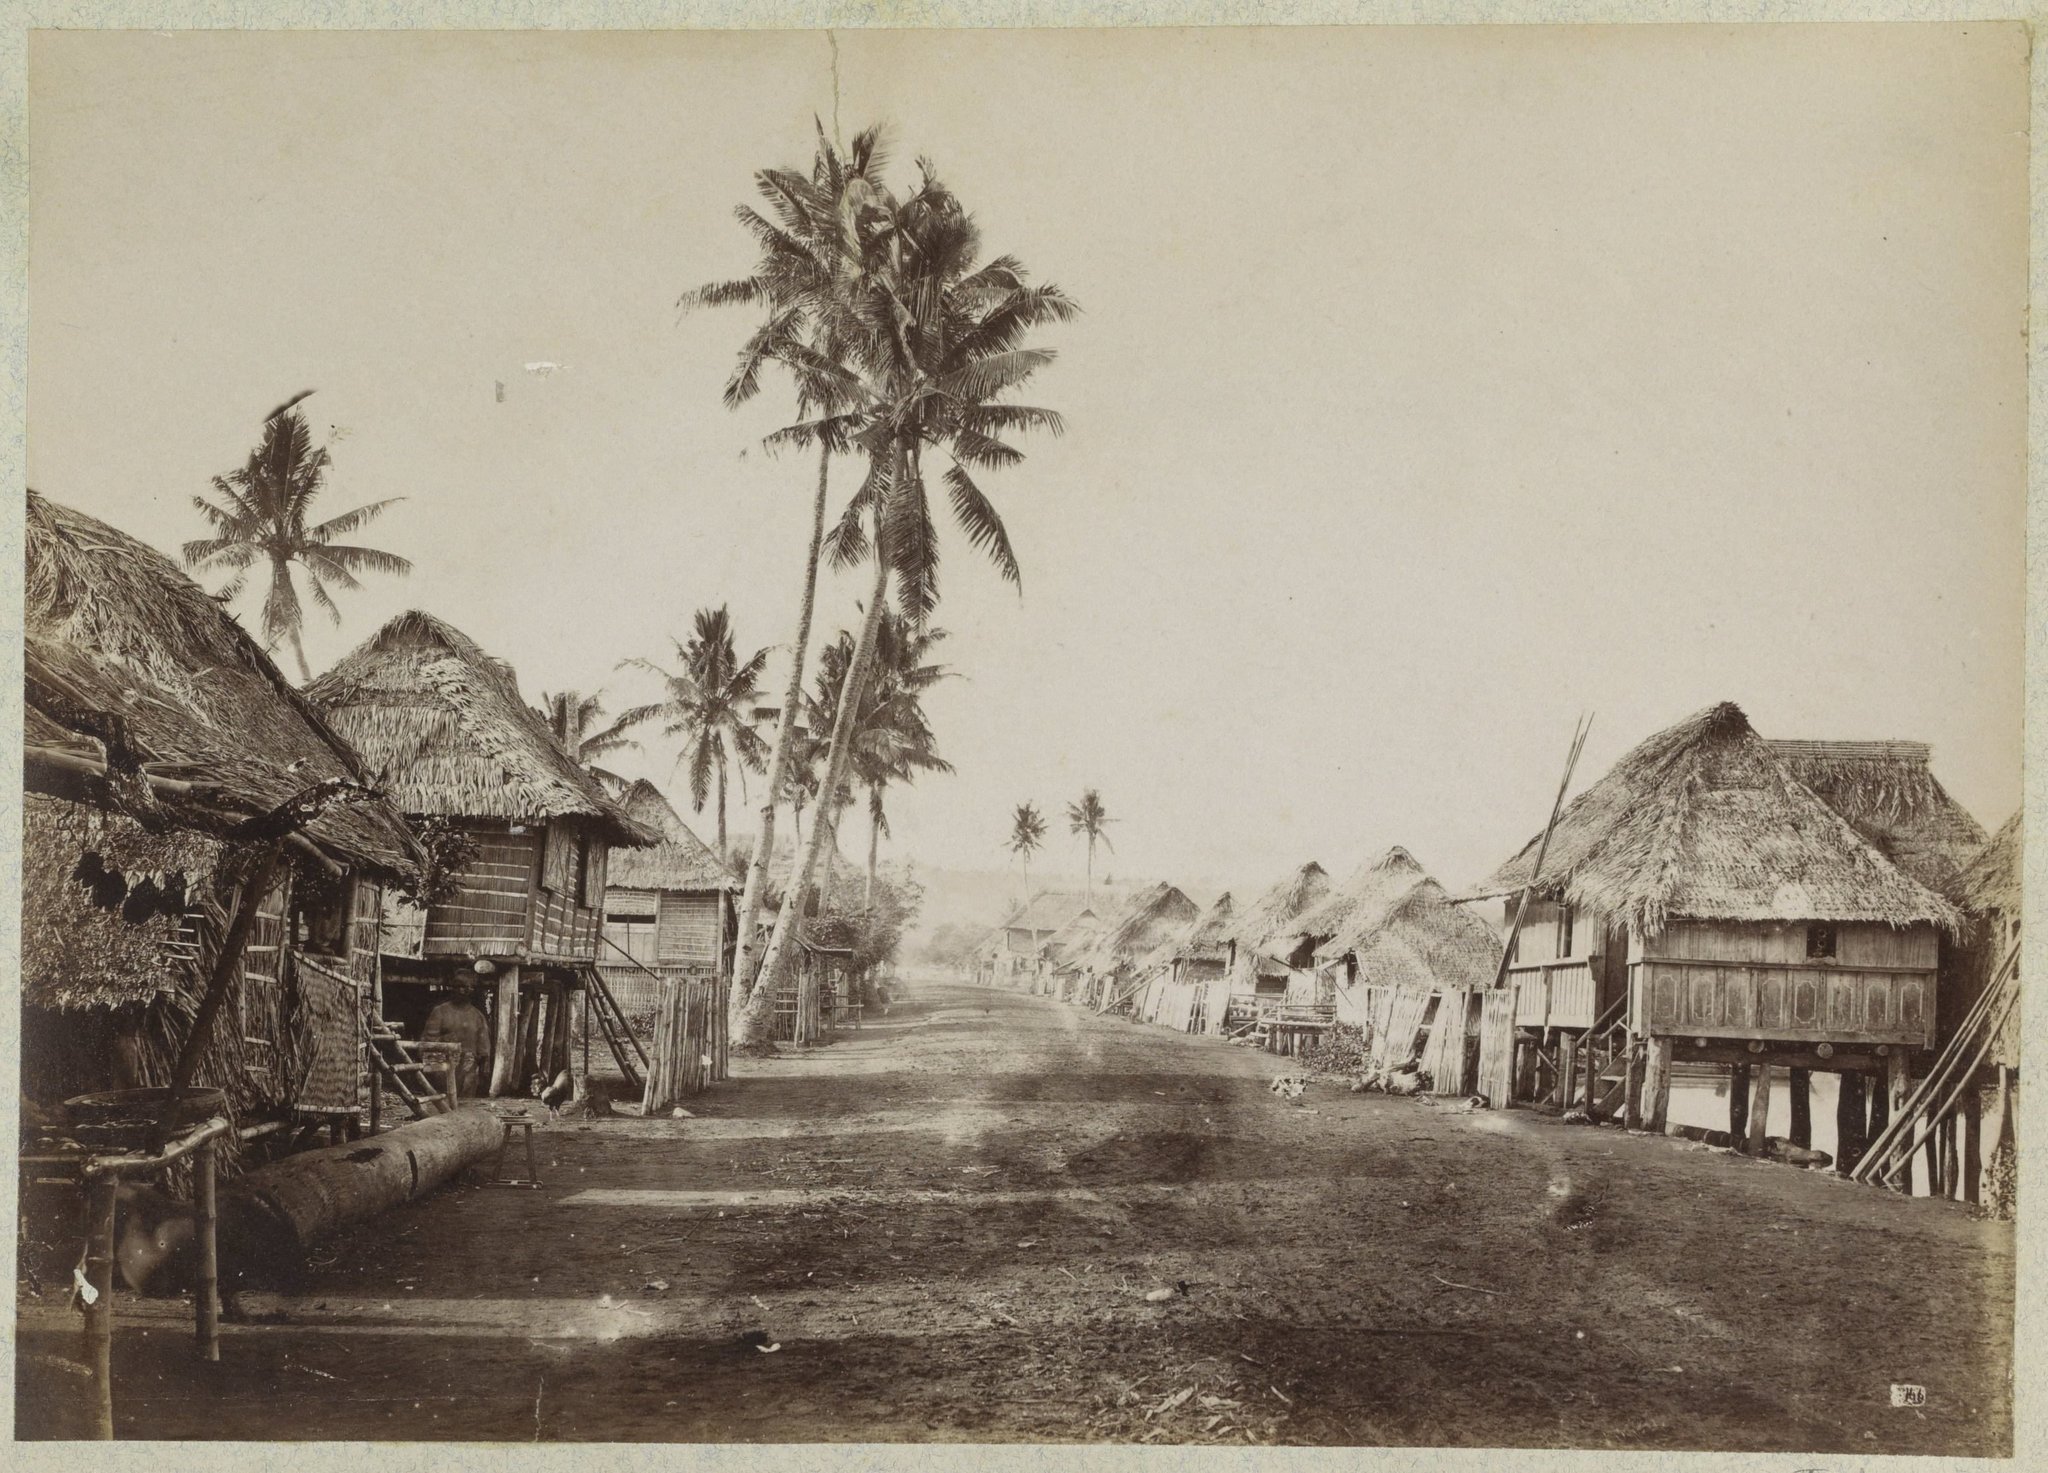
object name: photograph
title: Dorpsstraat met huizen met rieten daken, vermoedelijk op de Filipijnen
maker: Anonymous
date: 1870-1891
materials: paper, photographic support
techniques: albumen print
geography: philippines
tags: village street, philippines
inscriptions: number: ‘166’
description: Onderdeel van Fotoalbum van een reis naar Manilla.